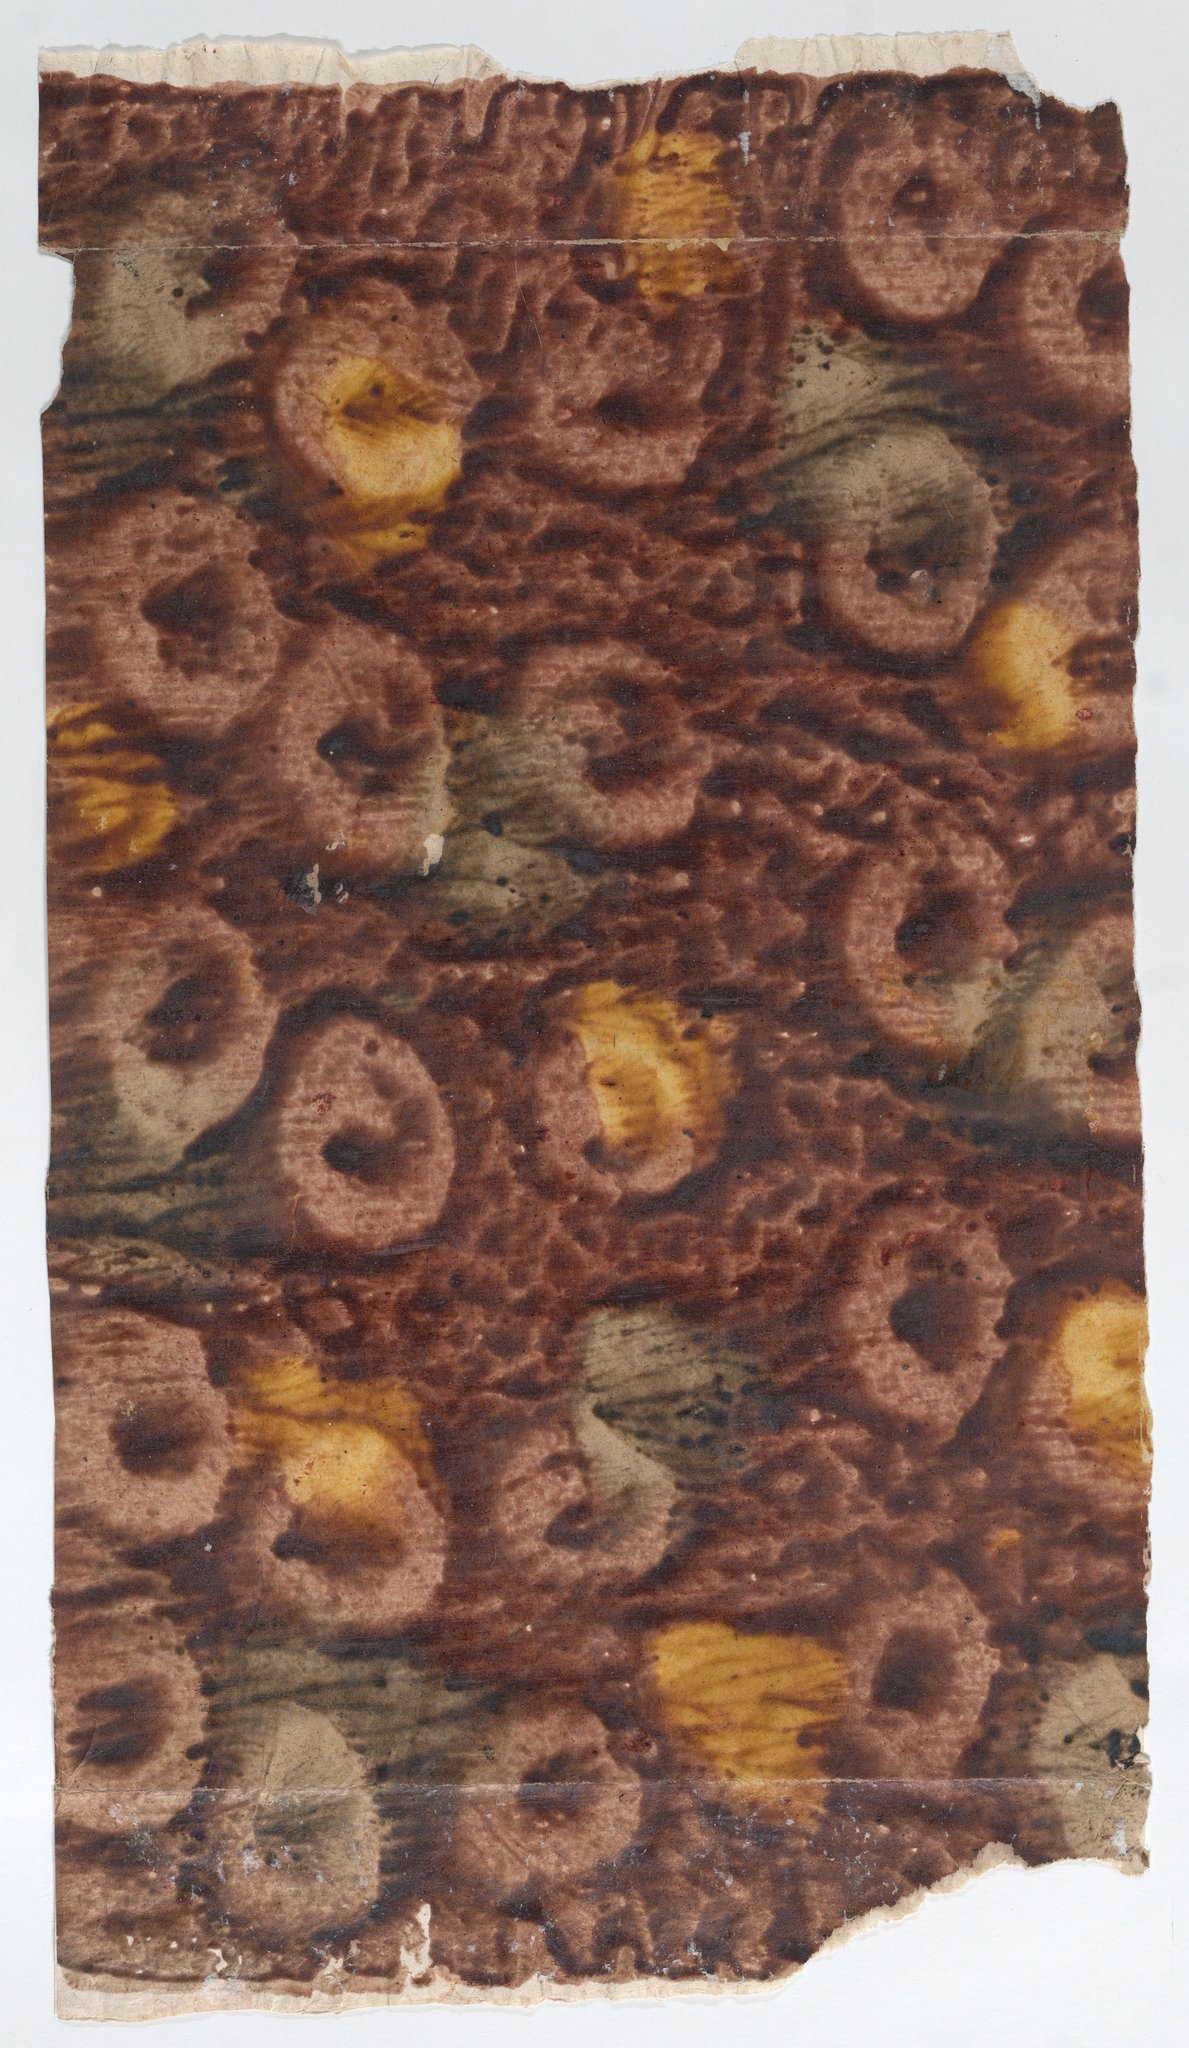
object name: print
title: Paste paper with purple, yellow, and green patterns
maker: Anonymous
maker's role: artist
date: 1701-1800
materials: paper, paste